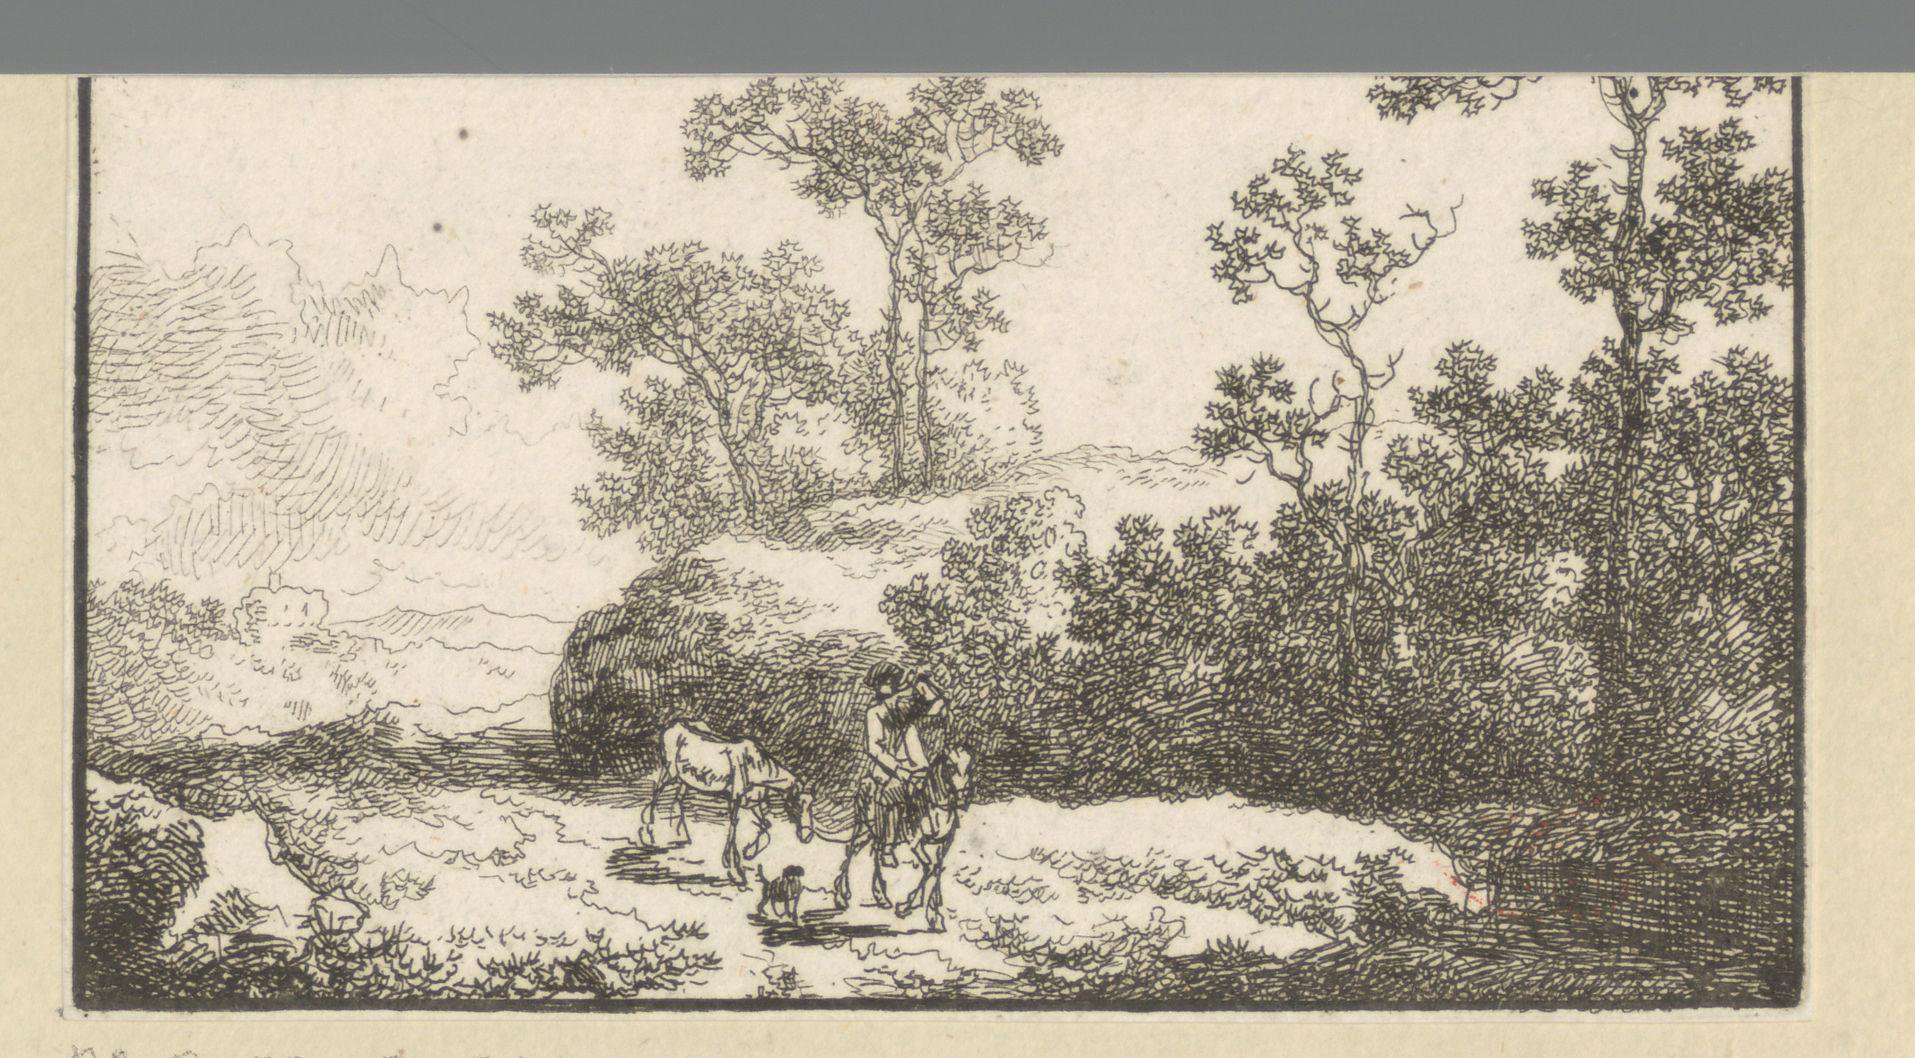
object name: print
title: Landschap met ruiter met een paard aan de teugel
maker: johann christian klengel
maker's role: print maker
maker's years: 1751-1824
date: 1761-1824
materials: paper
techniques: etching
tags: low hill country, horse, 'en route', traveller under way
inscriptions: collector's mark: Lugt 240